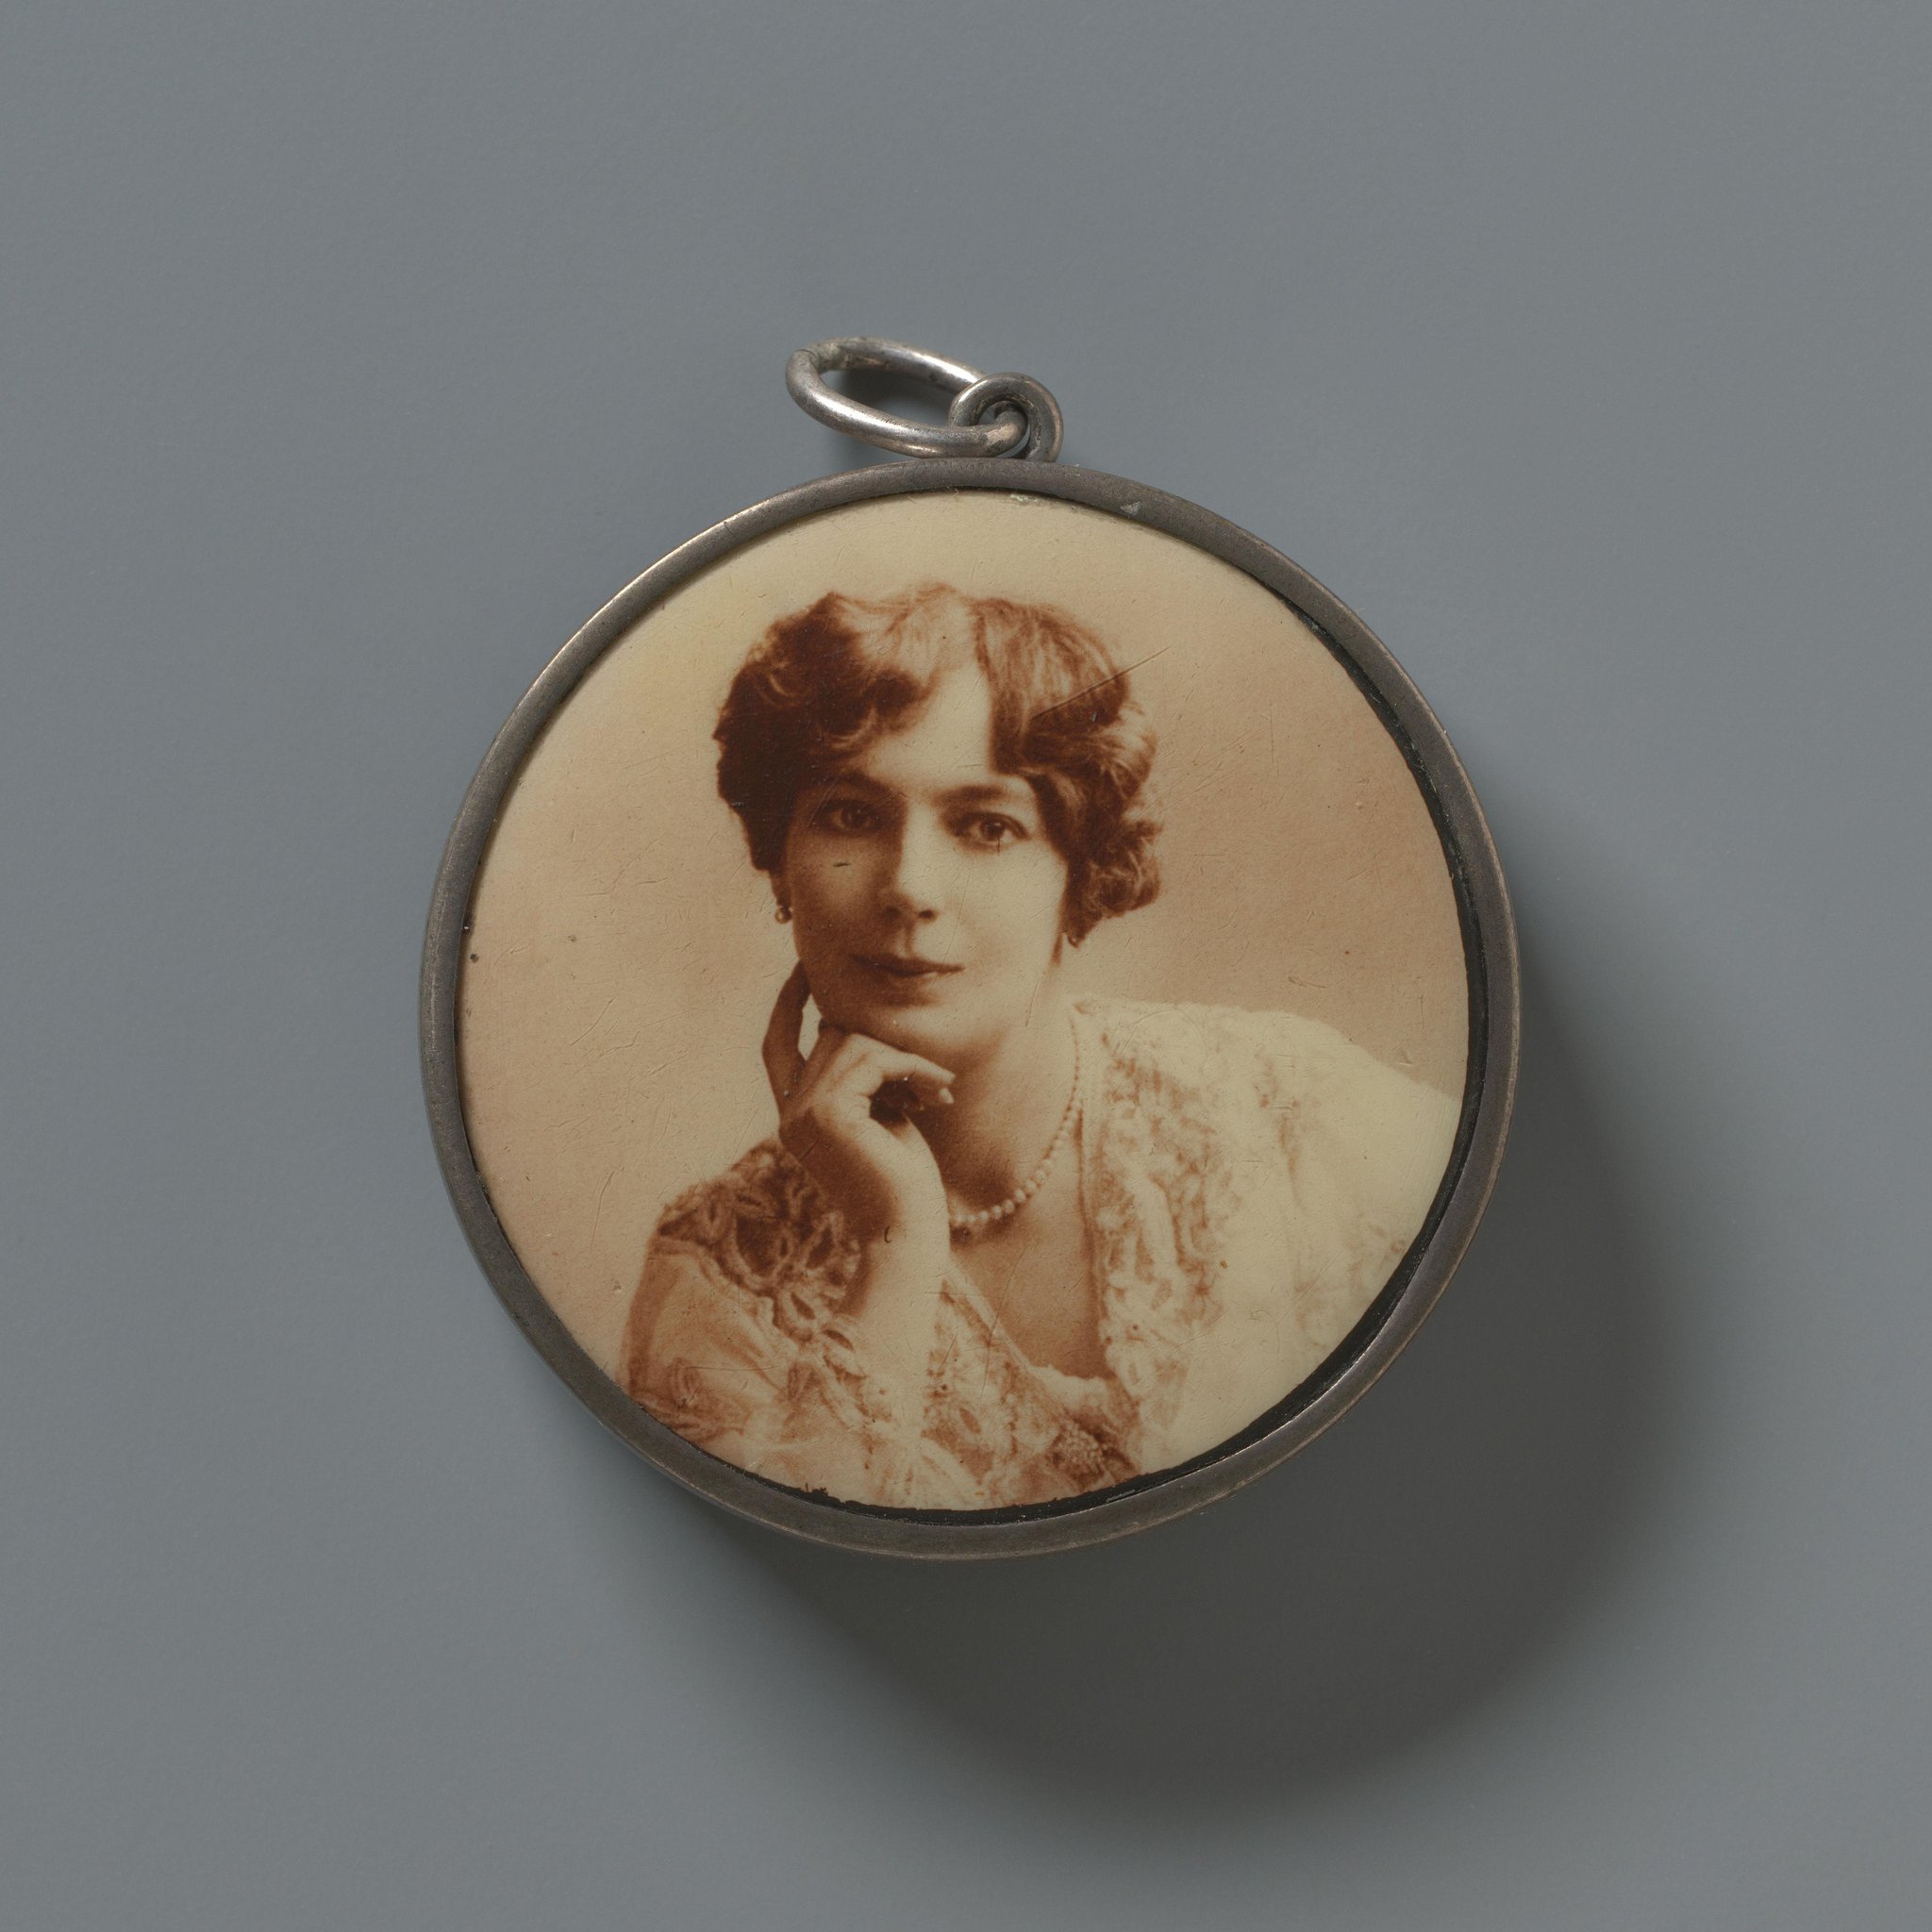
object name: pendant jewelry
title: Portret van een onbekende vrouw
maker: Anonymous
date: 1880-1930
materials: metal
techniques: enamel photograph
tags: historical persons - bb - woman